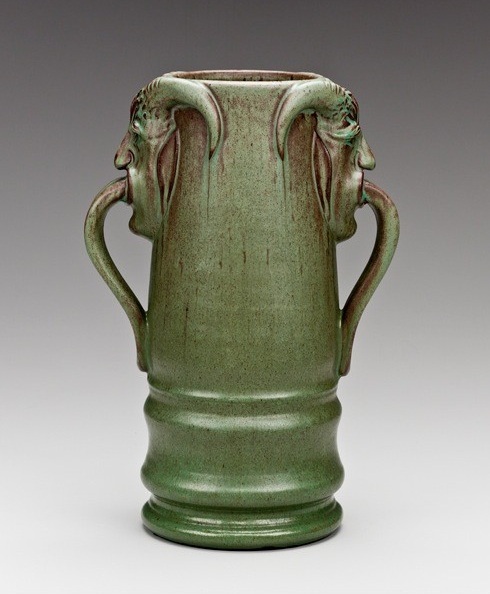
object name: vase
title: Vase with Satyr-head handles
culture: american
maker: william j. walley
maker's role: maker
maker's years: 1852-1919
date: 1898-1919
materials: glaze, stoneware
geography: united states